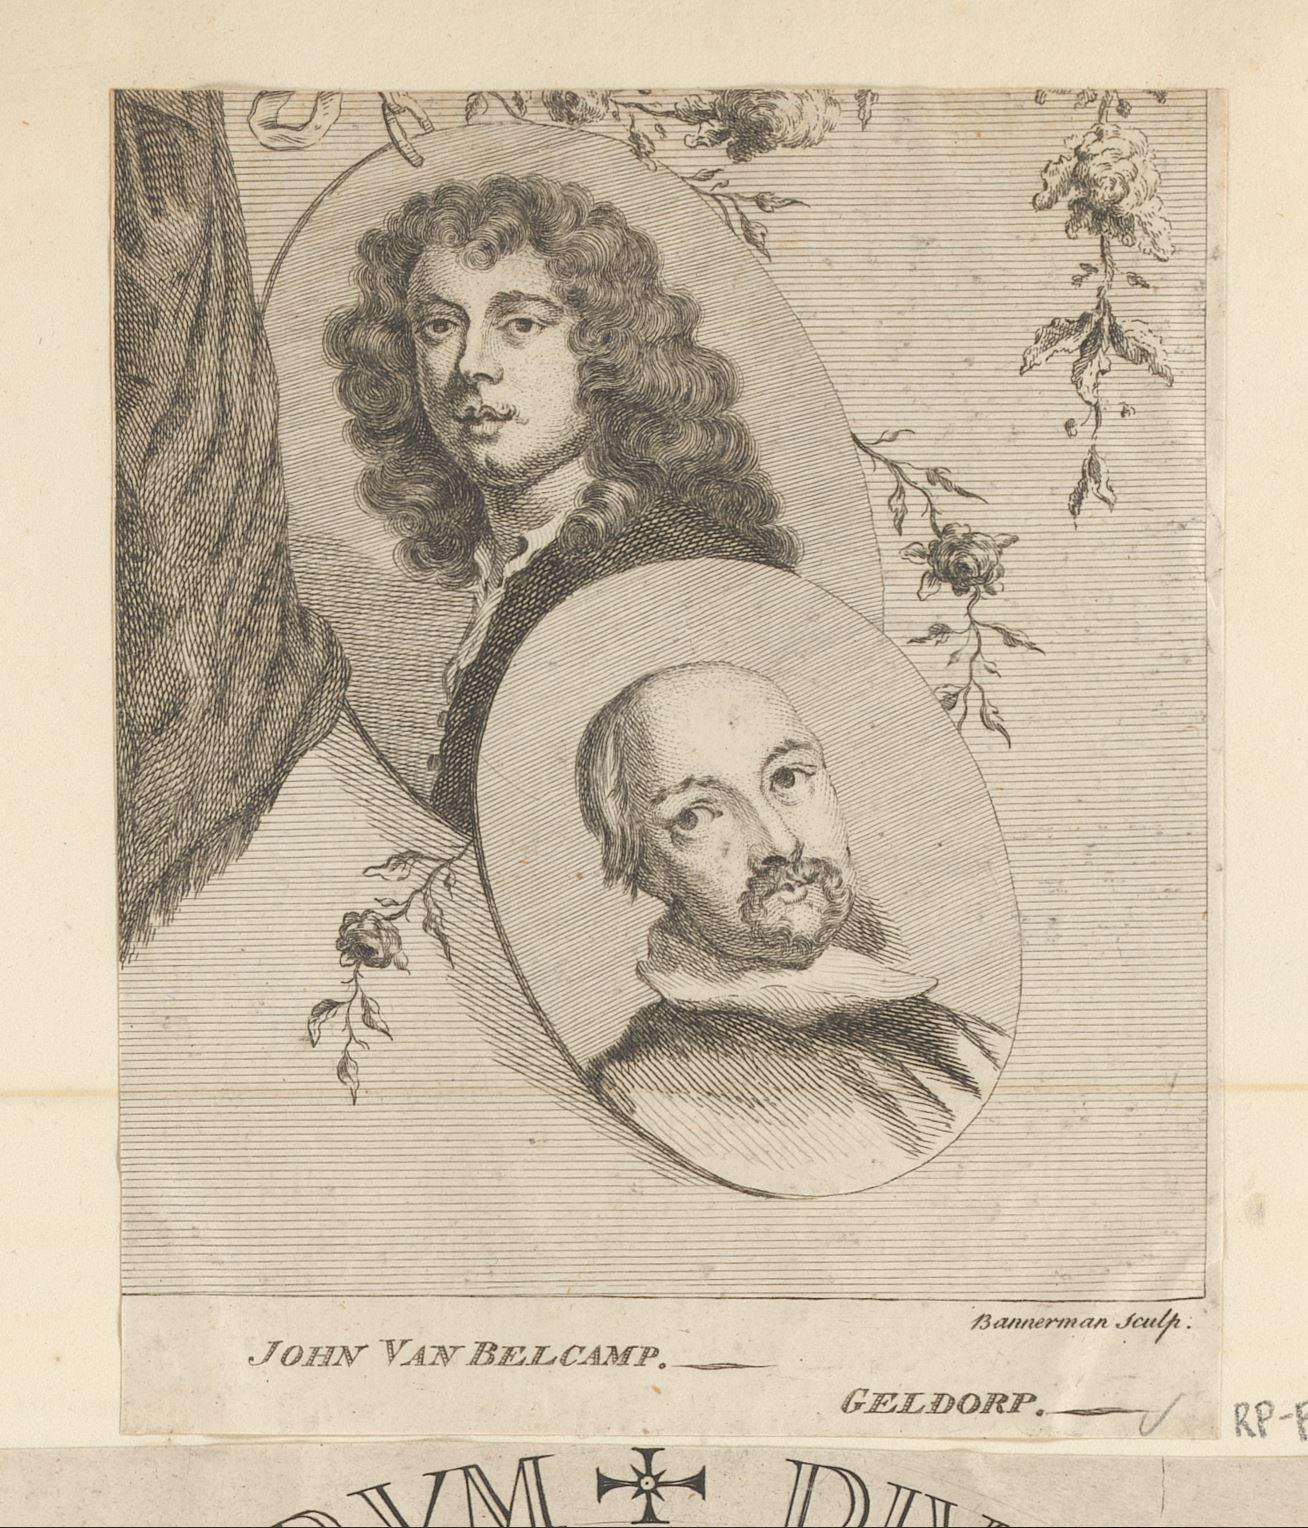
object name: print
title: Portret van Gortizius Geldorp en Jan van Belkamp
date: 1762-1789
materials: paper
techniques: engraving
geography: london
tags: antwerp, london, painter, louvain, gortzius geldorp, historical persons, portrait, self-portrait of painter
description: Prent uit: Walpole, Horace. Anecdotes of painting in England : with some account of the principal artists : and incidental notes on other arts; collected by the late Mr. George Vertue : and now digested and published from his original Mss. / by Horace Walpole. 4 dln. Londen: Horace Walpole, [1762-1789], dl. 2, p. 101. De samensteller heeft deze prent in het album geplakt als illustratie bij: Pilkington, Matthew en Johann Heinrich Füssli. A dictionary of painters, from the revival of the art to the present period. 4 dln. Londen: John Crowder, 1805, dl. 2, p. 214.